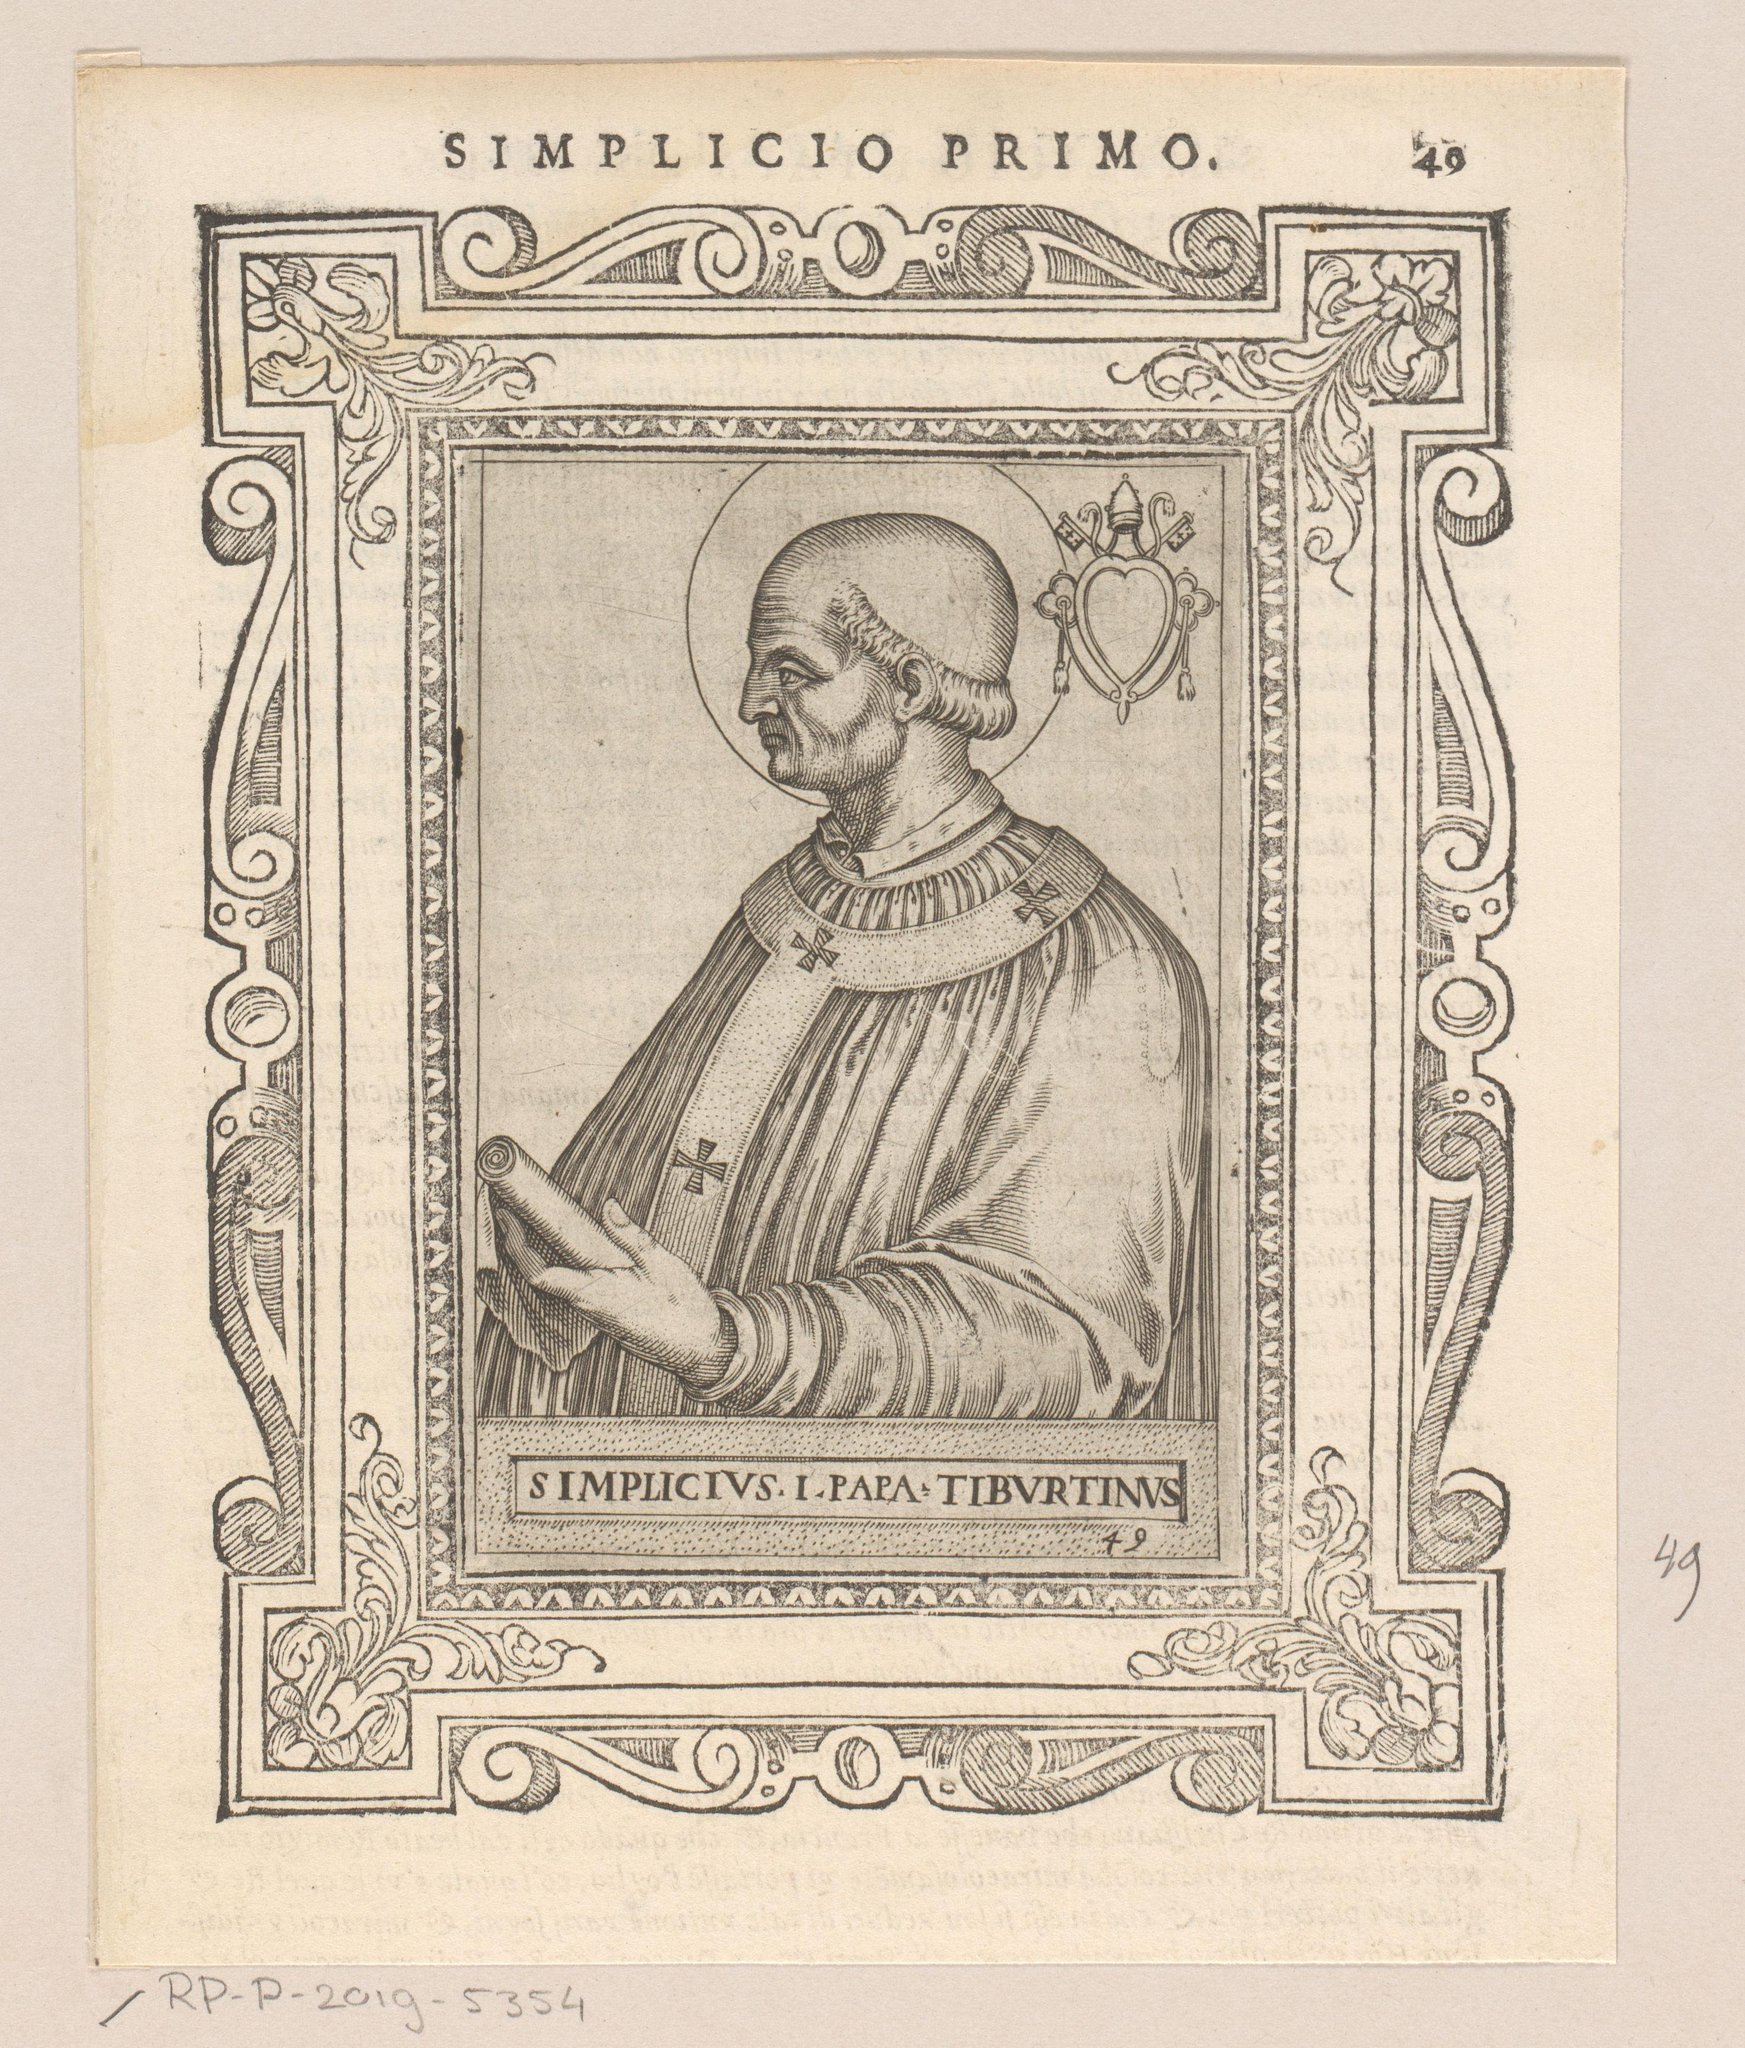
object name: book illustration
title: Simplicius I Papa Tiburtinus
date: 1587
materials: paper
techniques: engraving, letterpress printing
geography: rome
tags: tivoli, historical persons, pope, armorial bearing, heraldry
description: Prent uit: Ciccarelli, Antonio. Le vite de Pontefici di Antonio Ciccarelli (...). Rome: Domenico Basa, 1587. Prent voor het eerst verschenen in: Cavalieri, Giovanni Battista de'. Pontificum romanorum effigies (...). Rome: Domenico Basa en Francesco Zanetti, 1580. Prent ook gebruikt in latere publicaties.